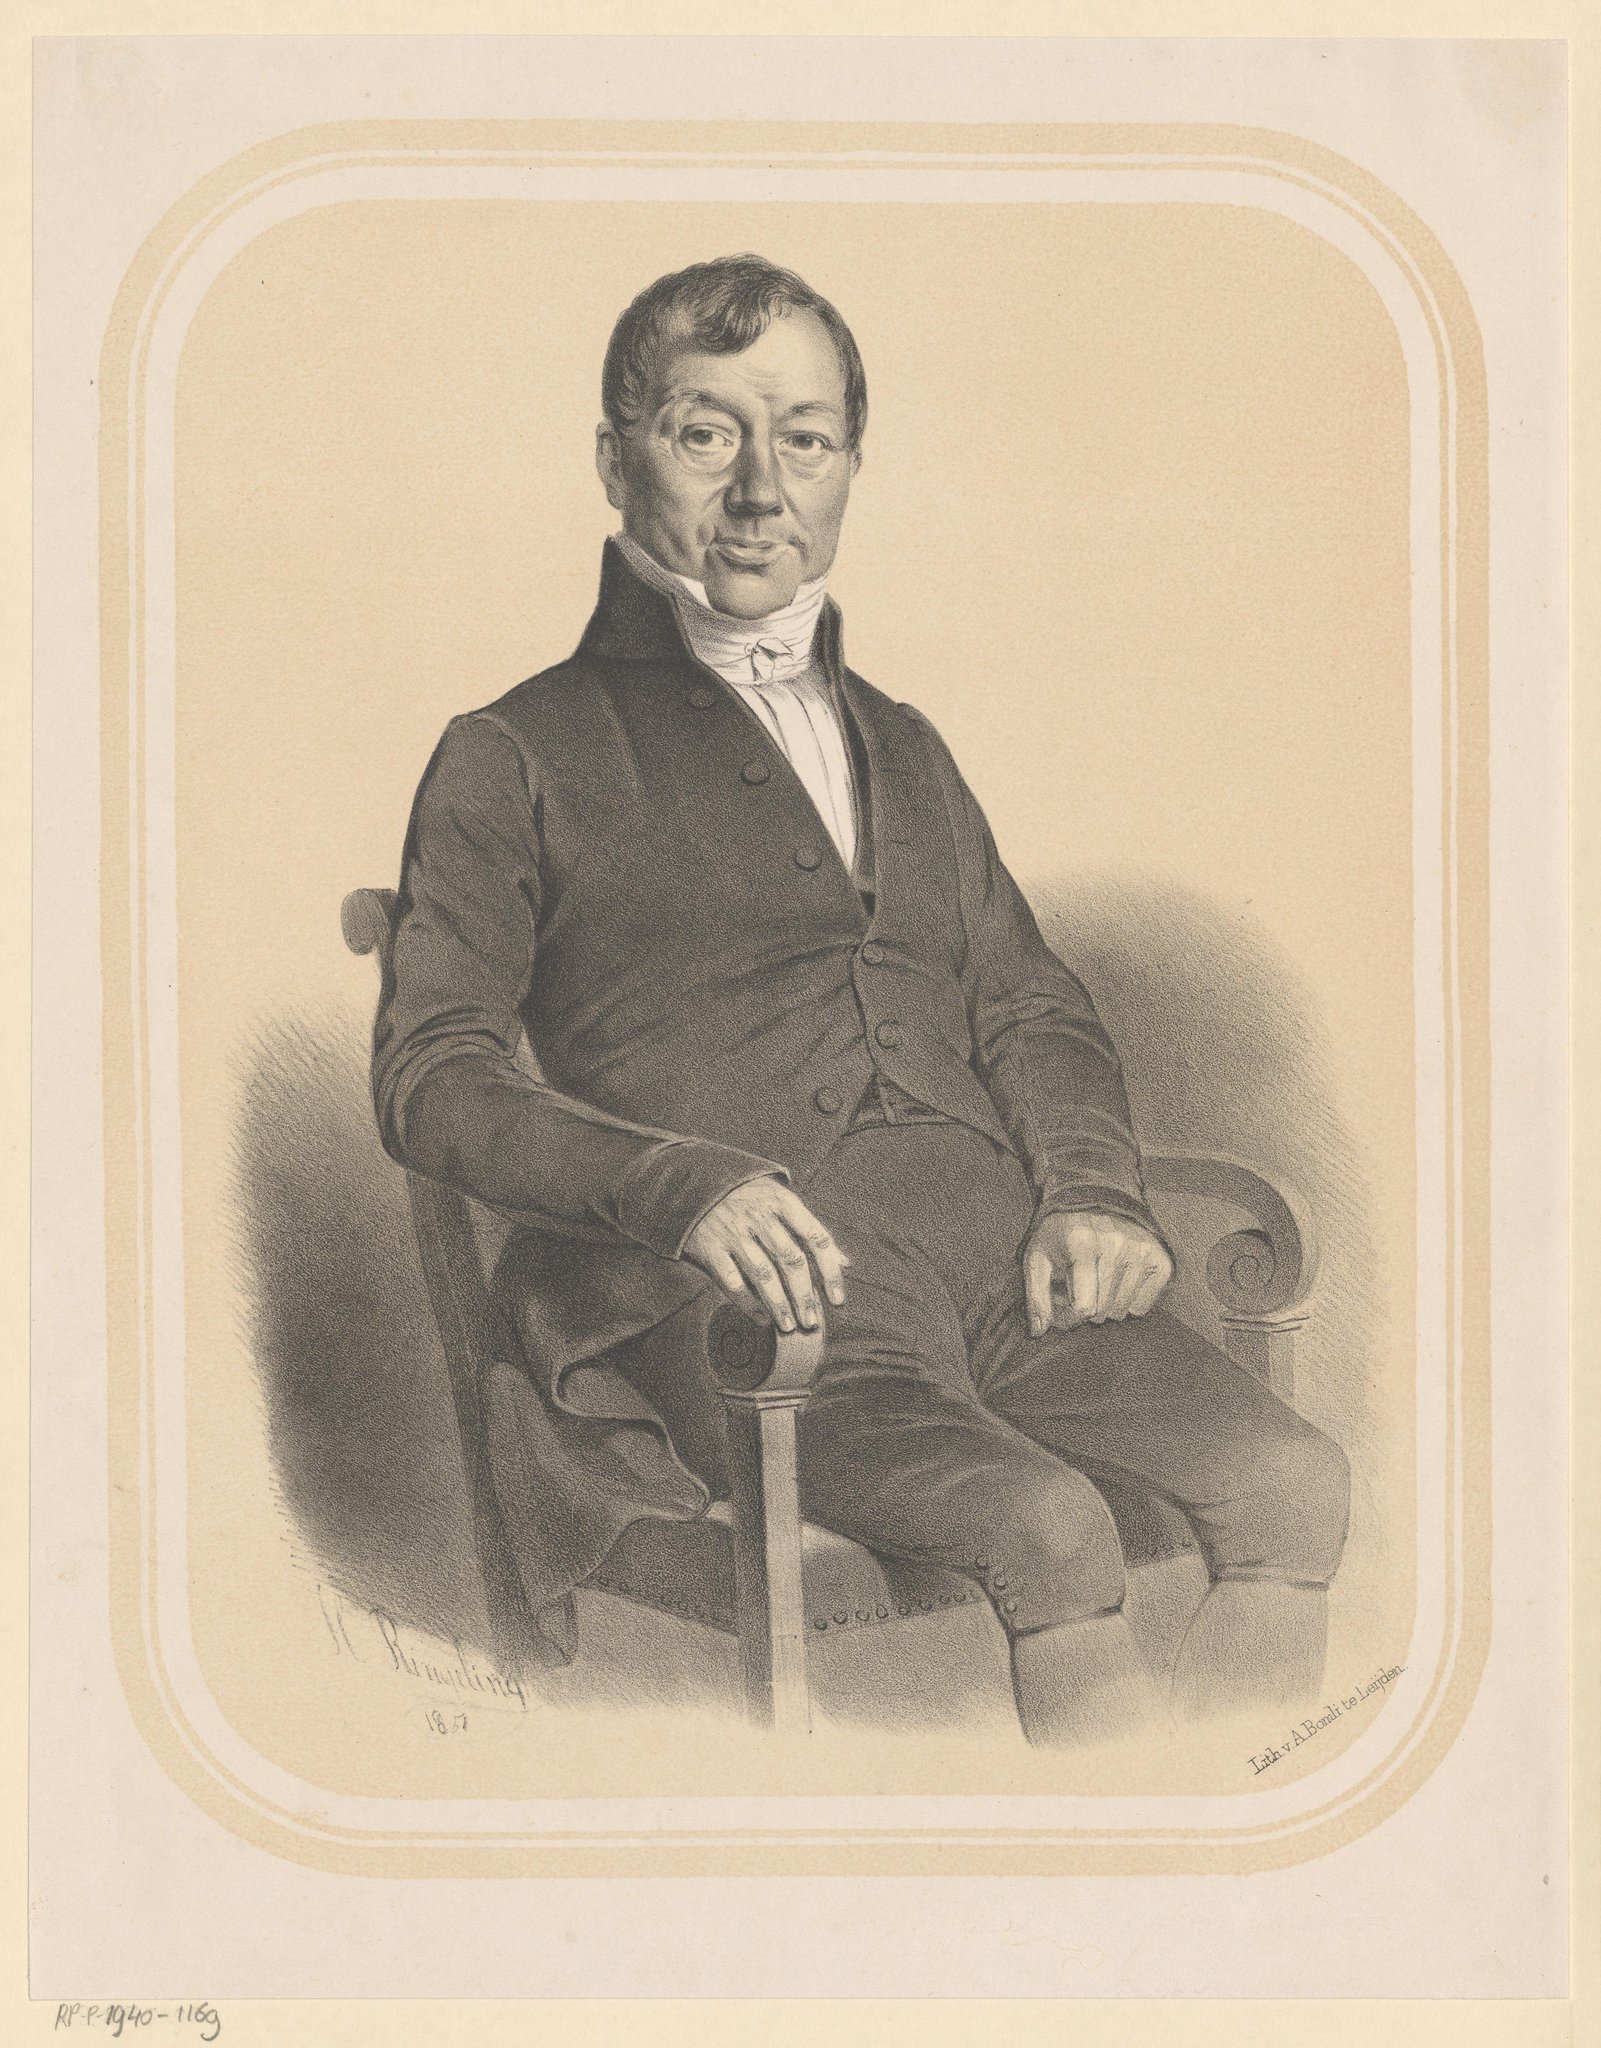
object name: print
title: Portret van Johannes Eusebius Voet van Campen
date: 1851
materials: paper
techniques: tone lithography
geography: leiden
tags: leiden, print maker, draughtsman, historical persons, portrait, self-portrait of painter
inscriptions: collector's mark: Lugt 2760, collector's mark: Lugt 2228